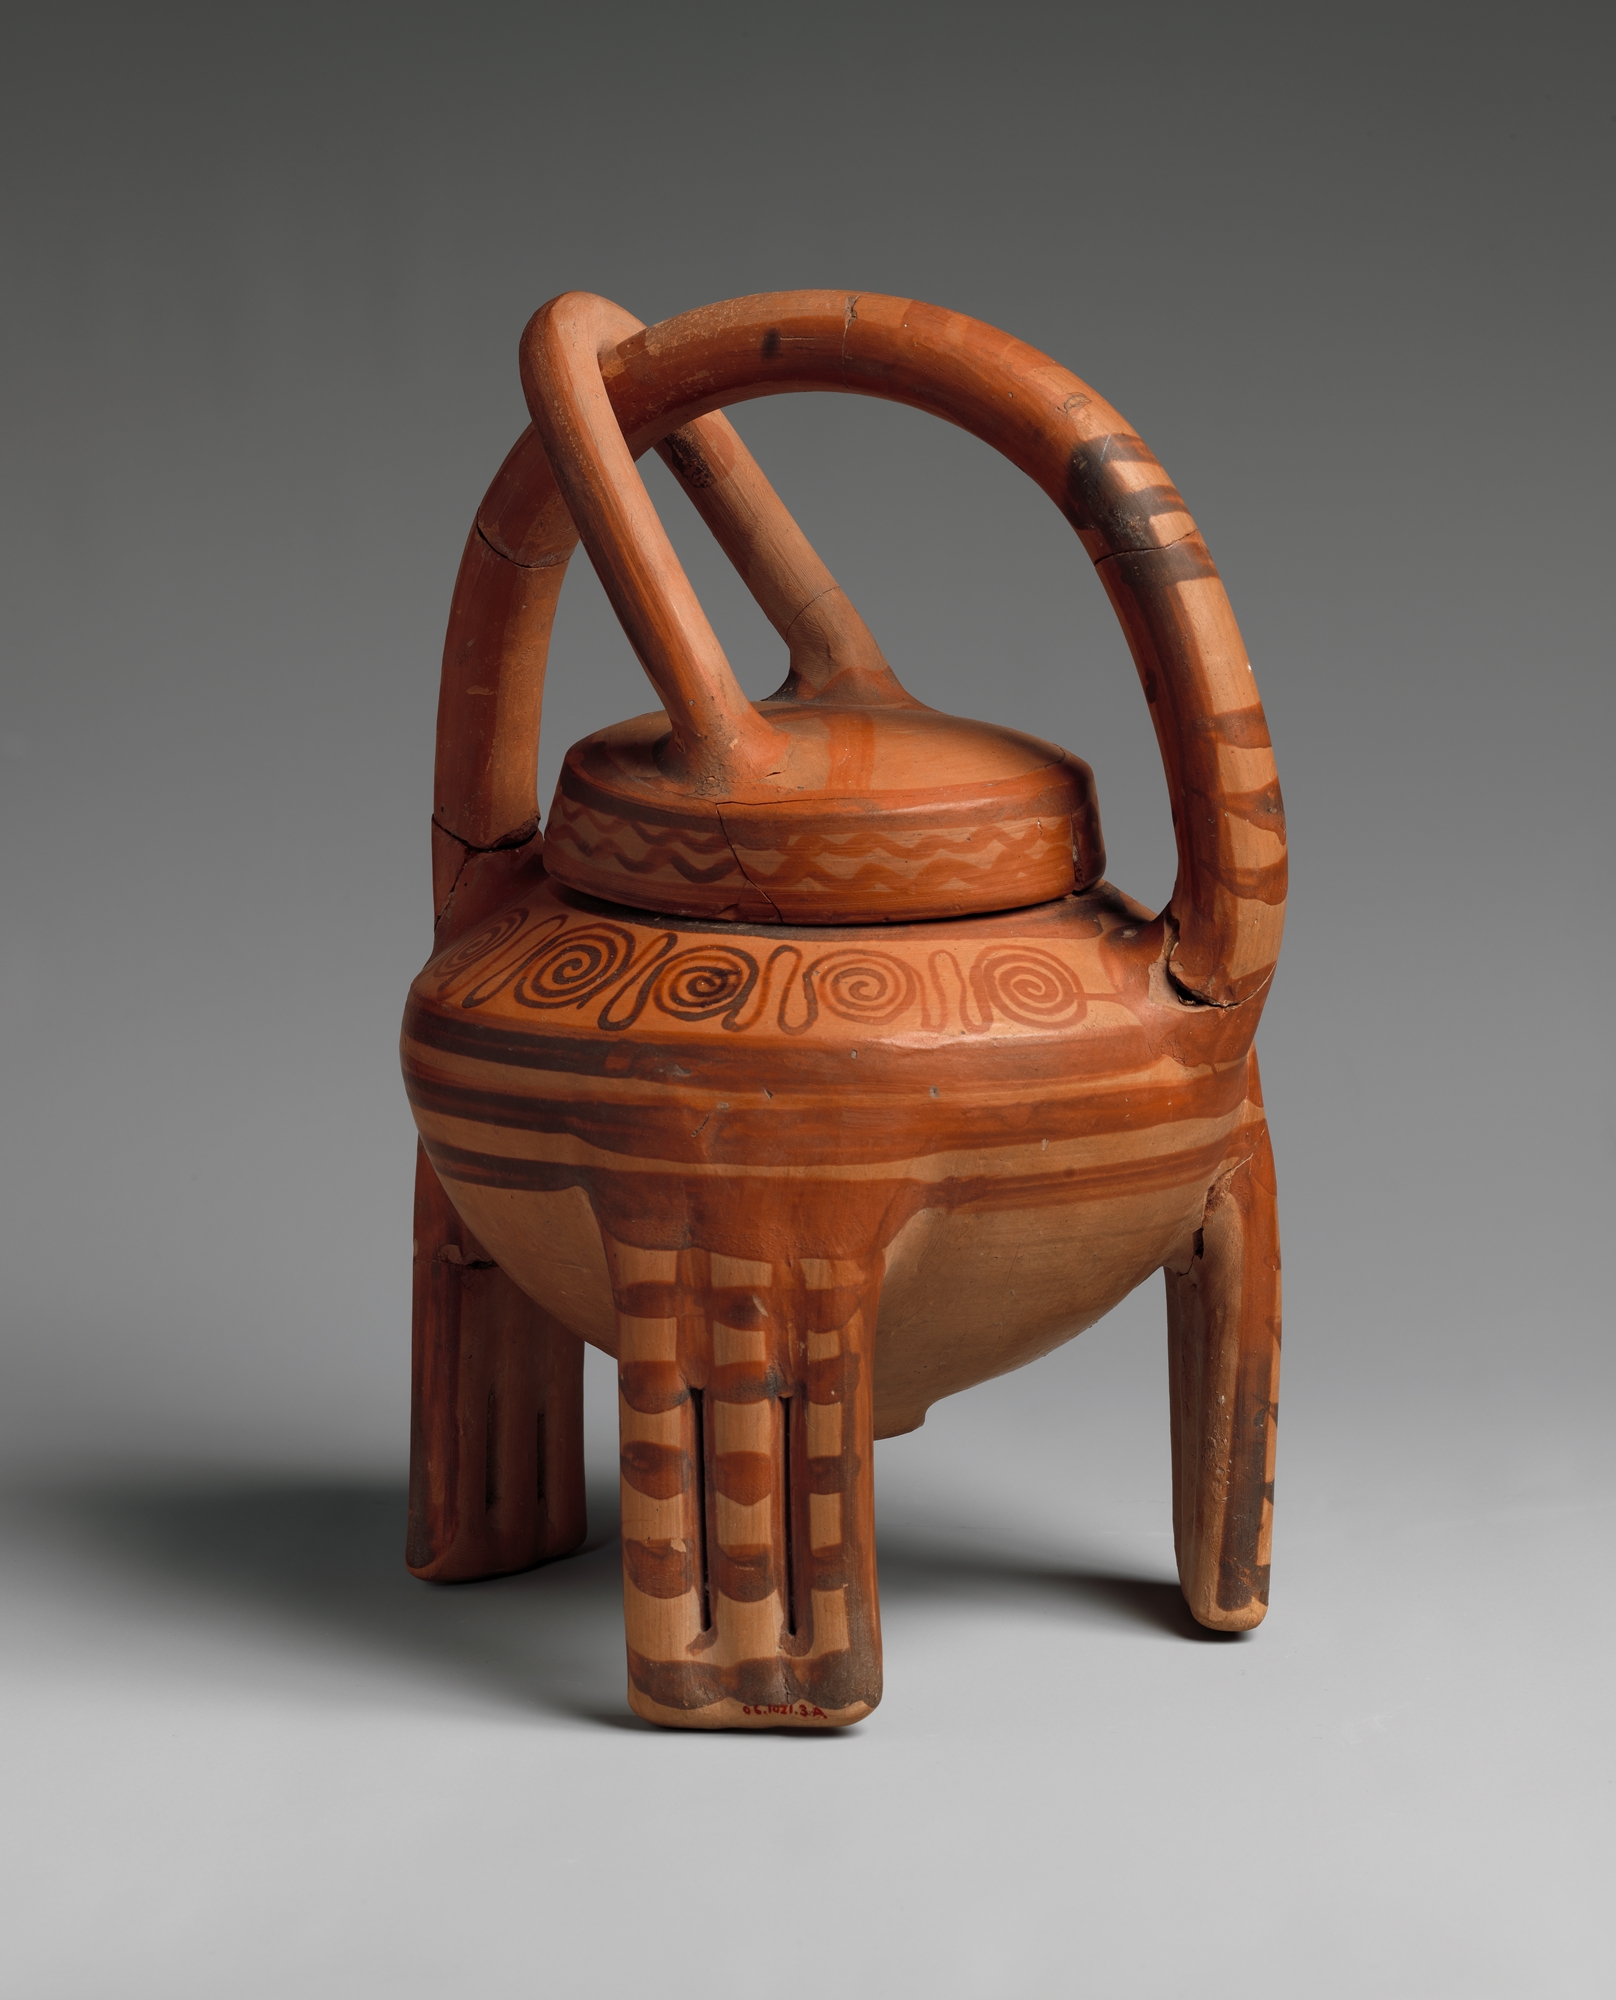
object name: vase in the form of a basket, with lid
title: Terracotta "basket vase"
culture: aegean, helladic or mycenaean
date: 1400-1300 BCE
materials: terracotta